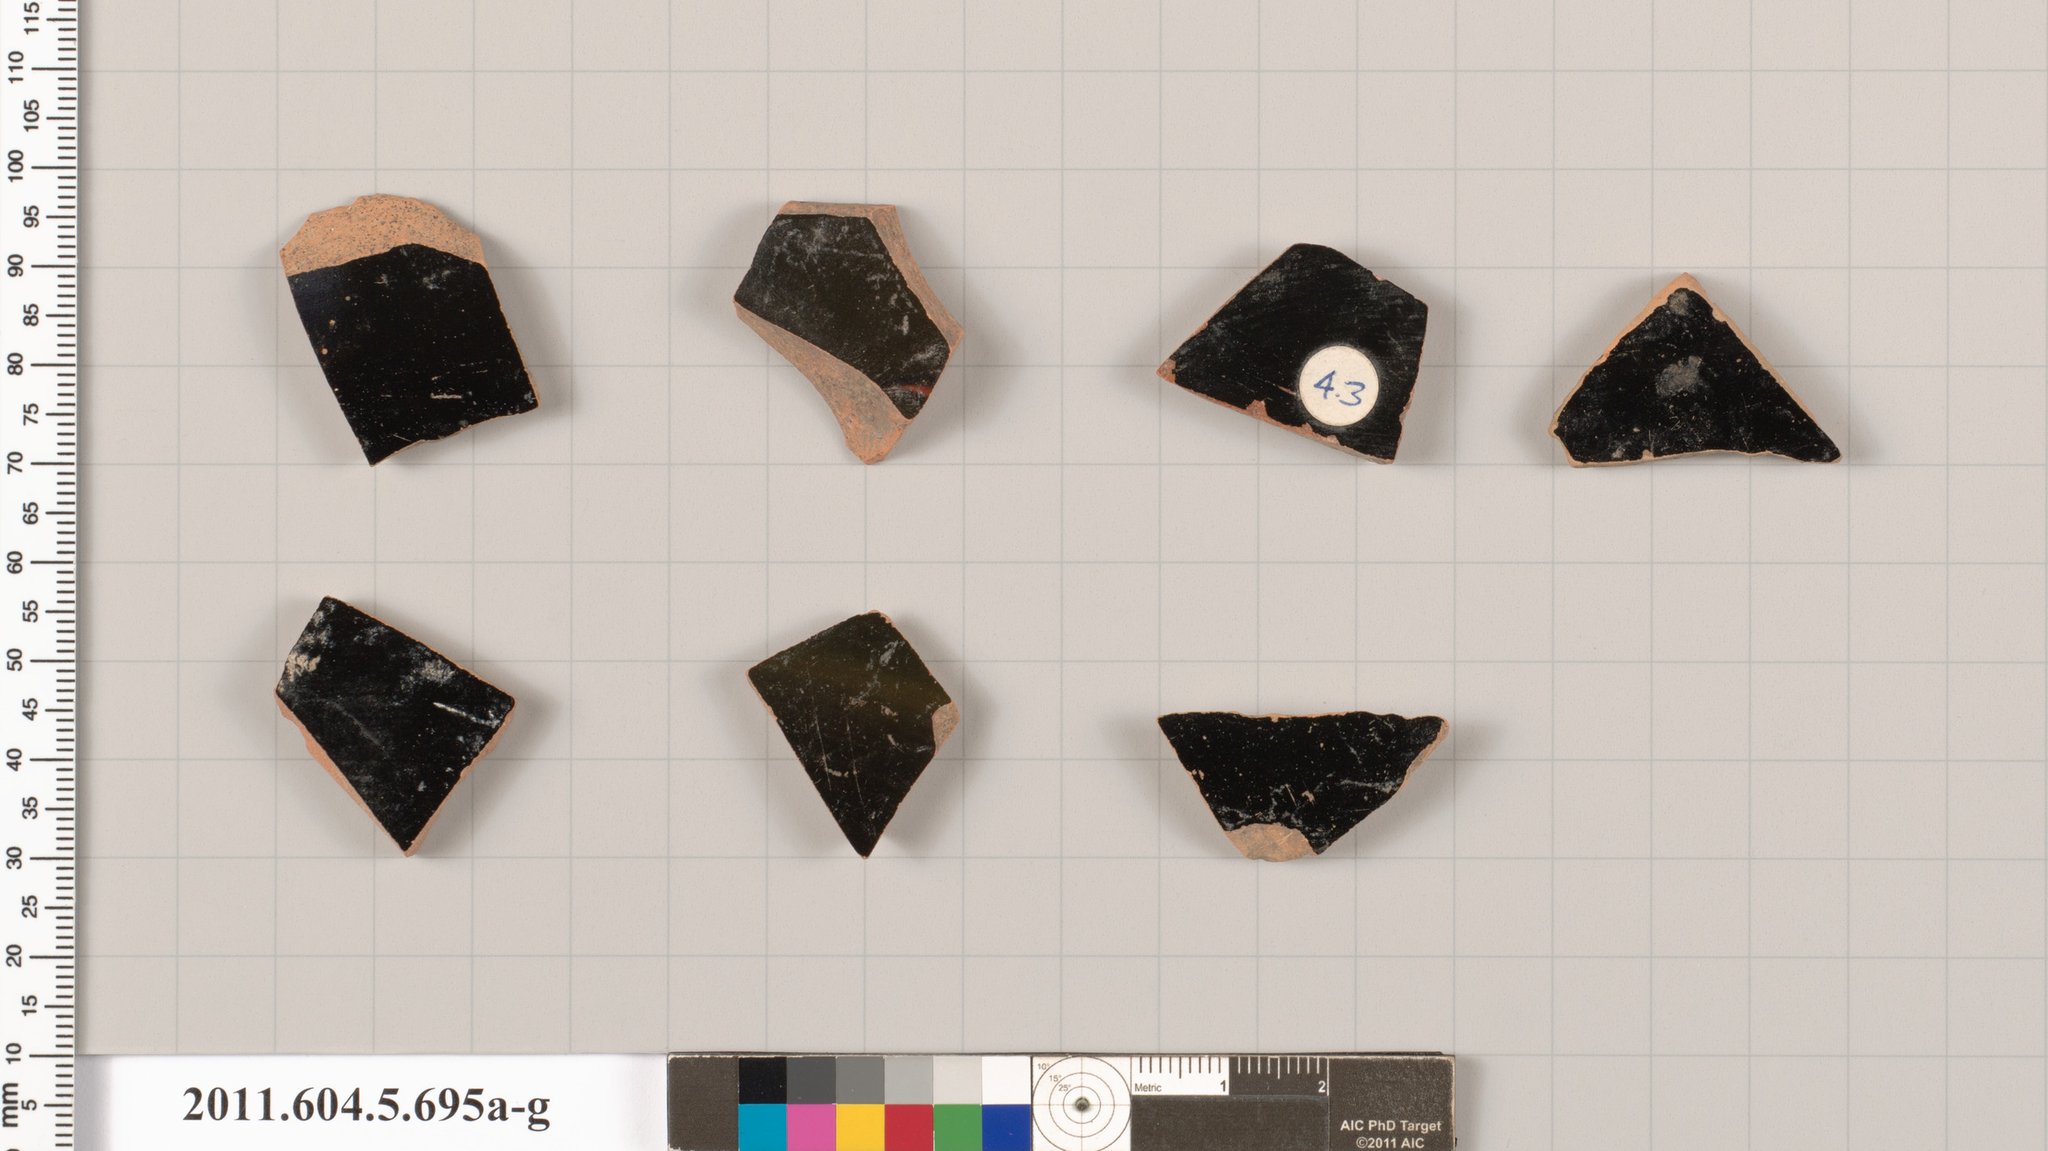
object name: kylix fragment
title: Terracotta fragments of kylikes (drinking cups)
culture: greek, attic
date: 600-401 BCE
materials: terracotta